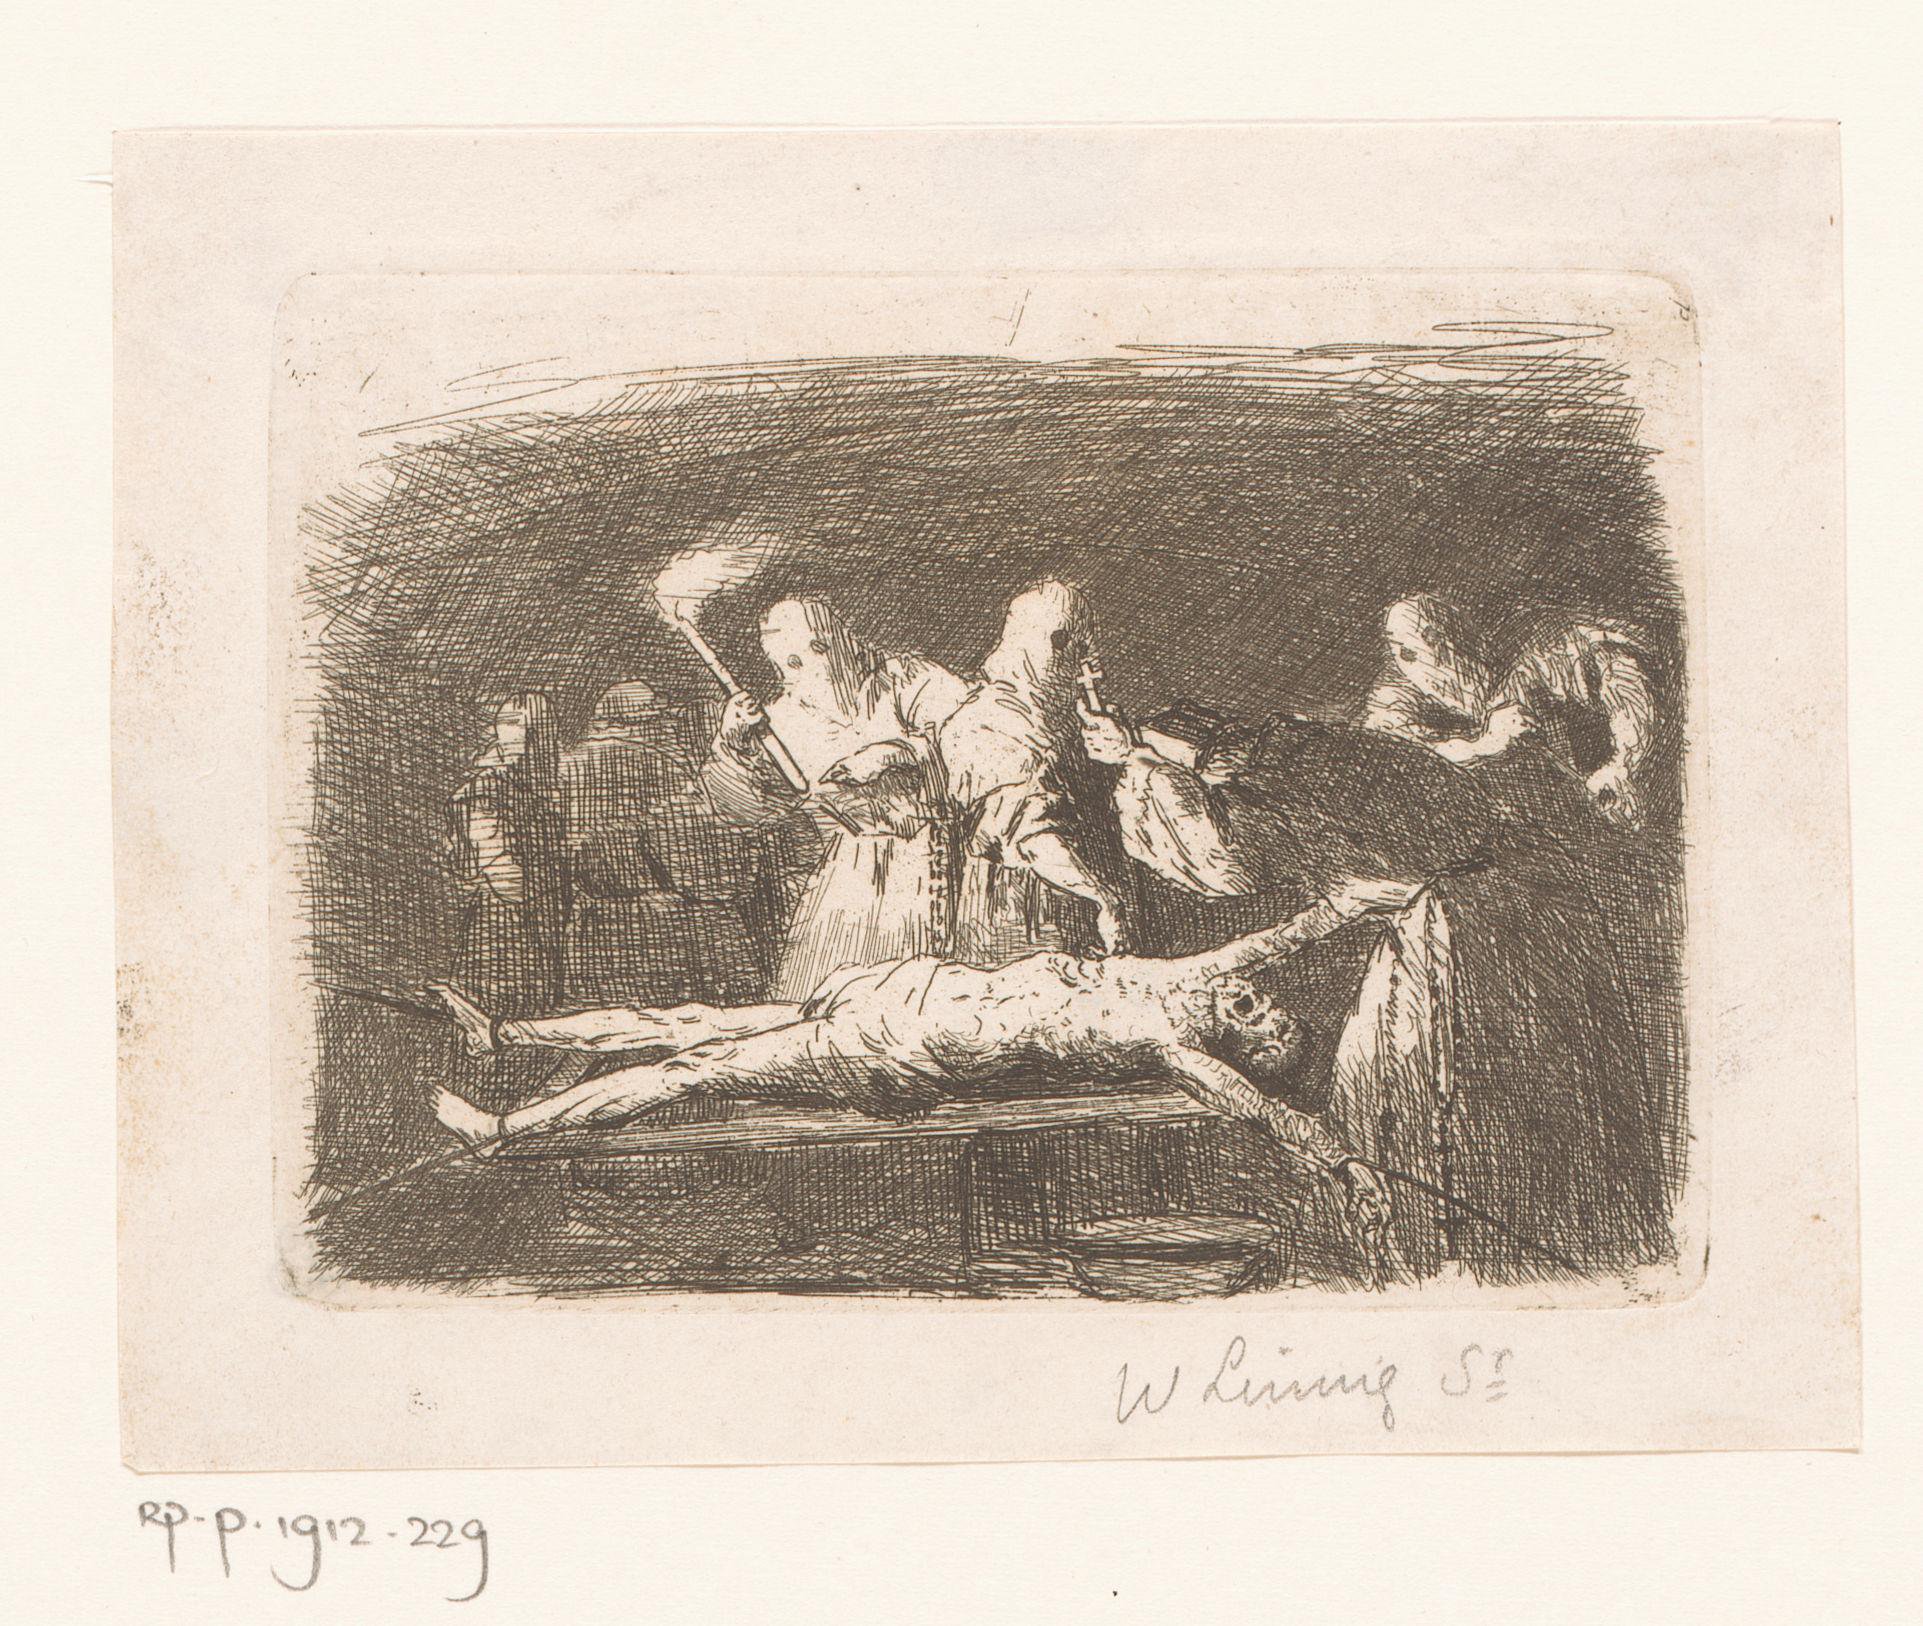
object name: print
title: Priester buigt zich over een man op de pijnbank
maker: willem linnig (i)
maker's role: print maker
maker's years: 1819-1885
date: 1829-1885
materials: paper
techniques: etching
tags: torture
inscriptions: collector's mark: Lugt 2228, collector's mark: Lugt 1485